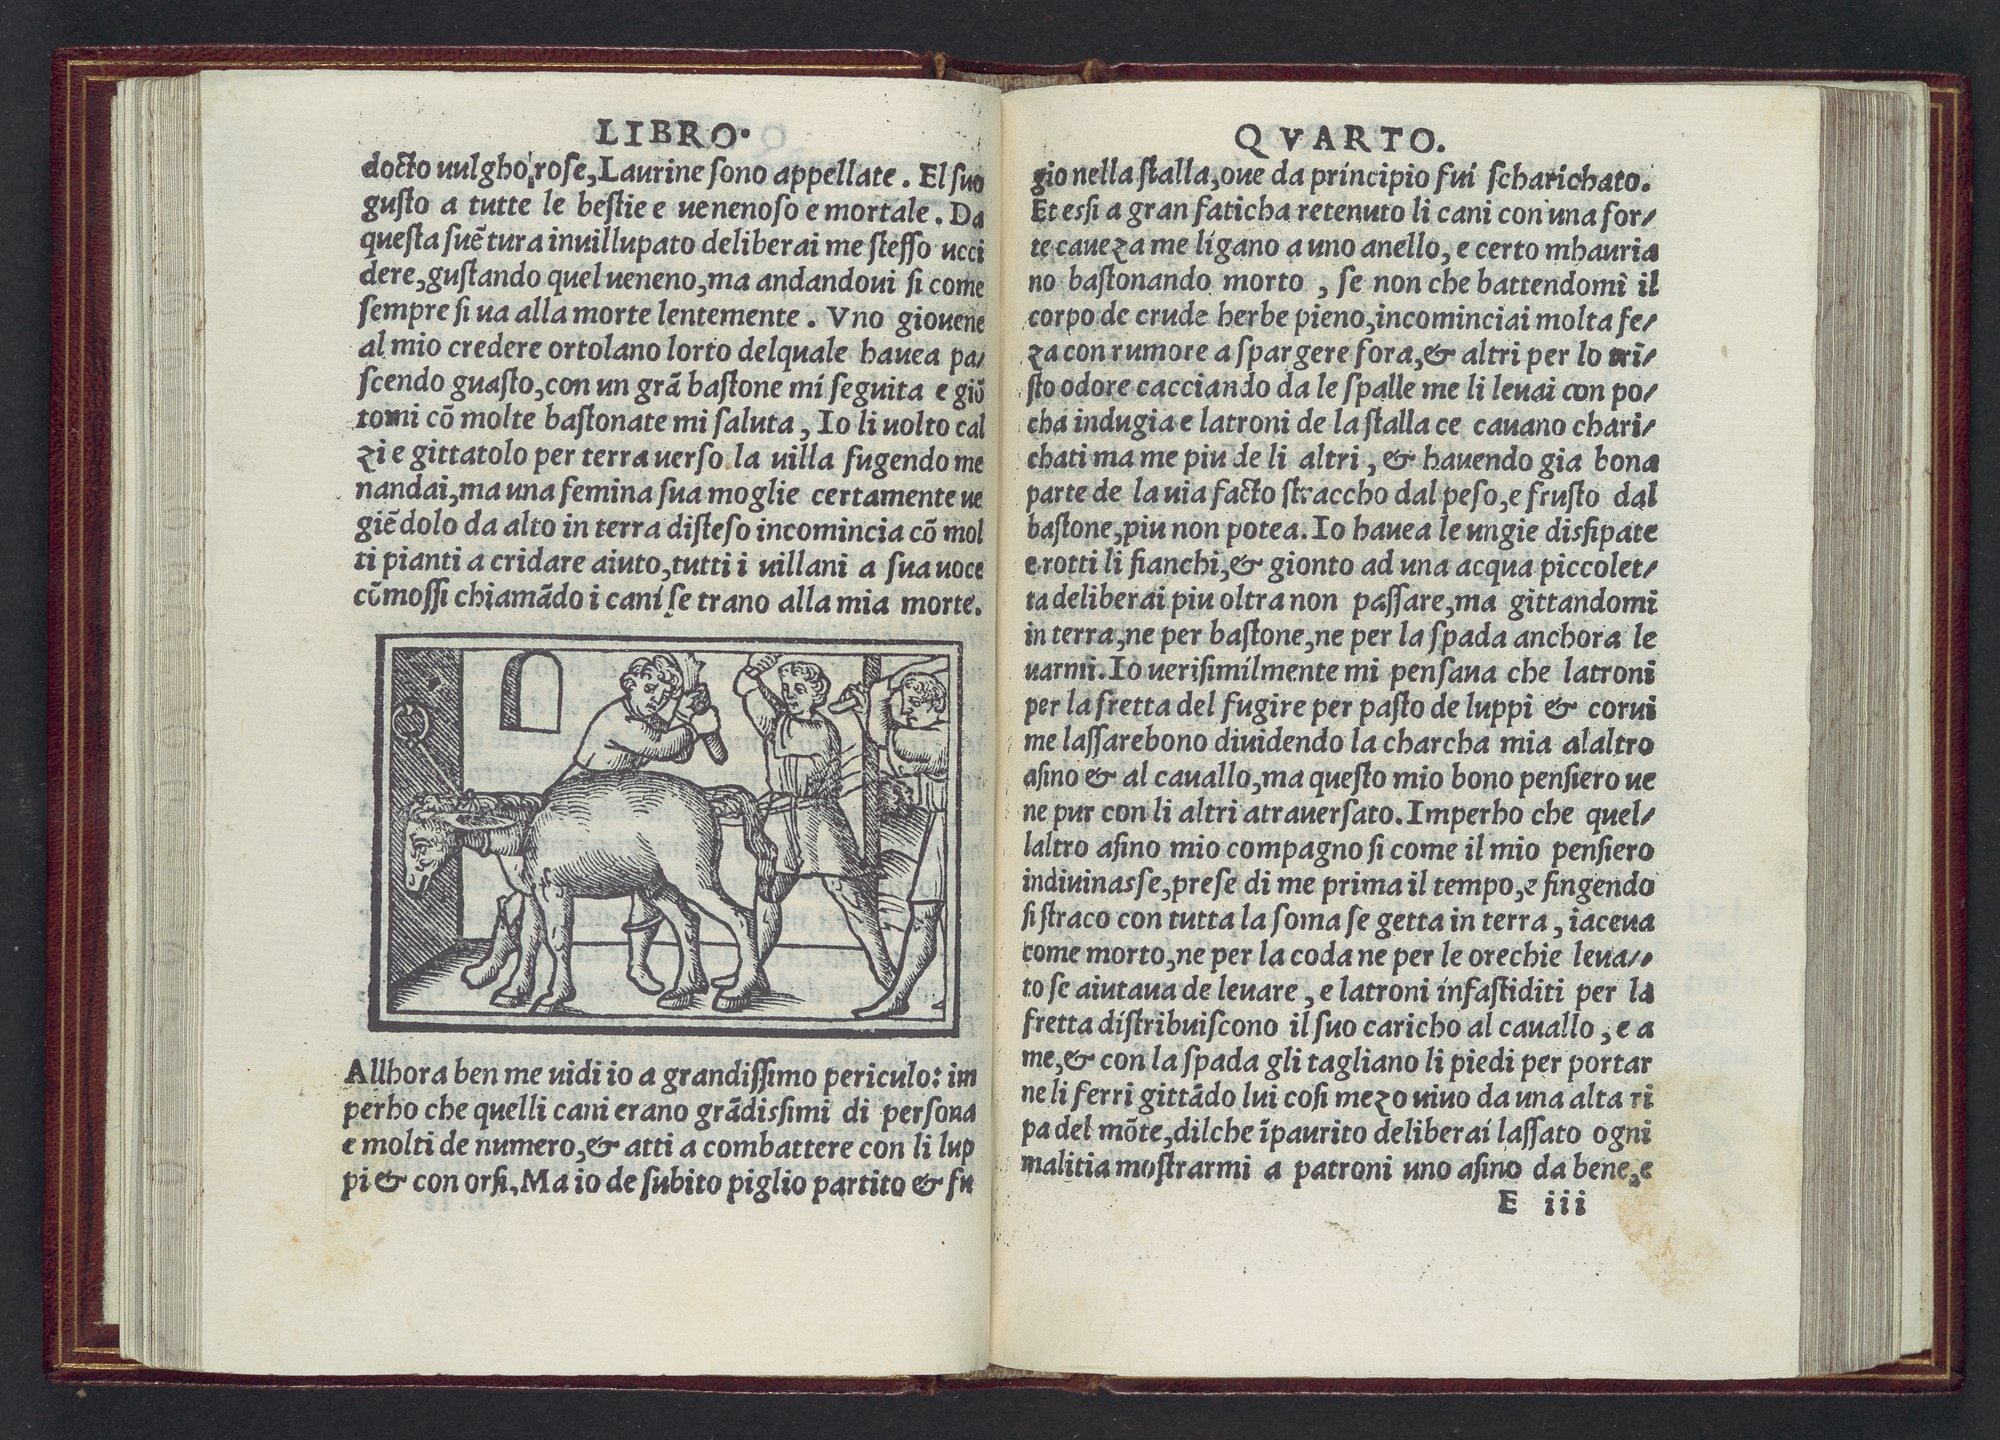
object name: book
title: Apulegio volgare, diuiso in undeci libri, novamente stampato & in molti lochi aggiontoui che nella prima impressione gli manchaua, & de molte più figure adornato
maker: lucius madaurensis apuleius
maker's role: author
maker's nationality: algerian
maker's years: 120-224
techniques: printing, woodcut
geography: italy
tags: men,donkeys